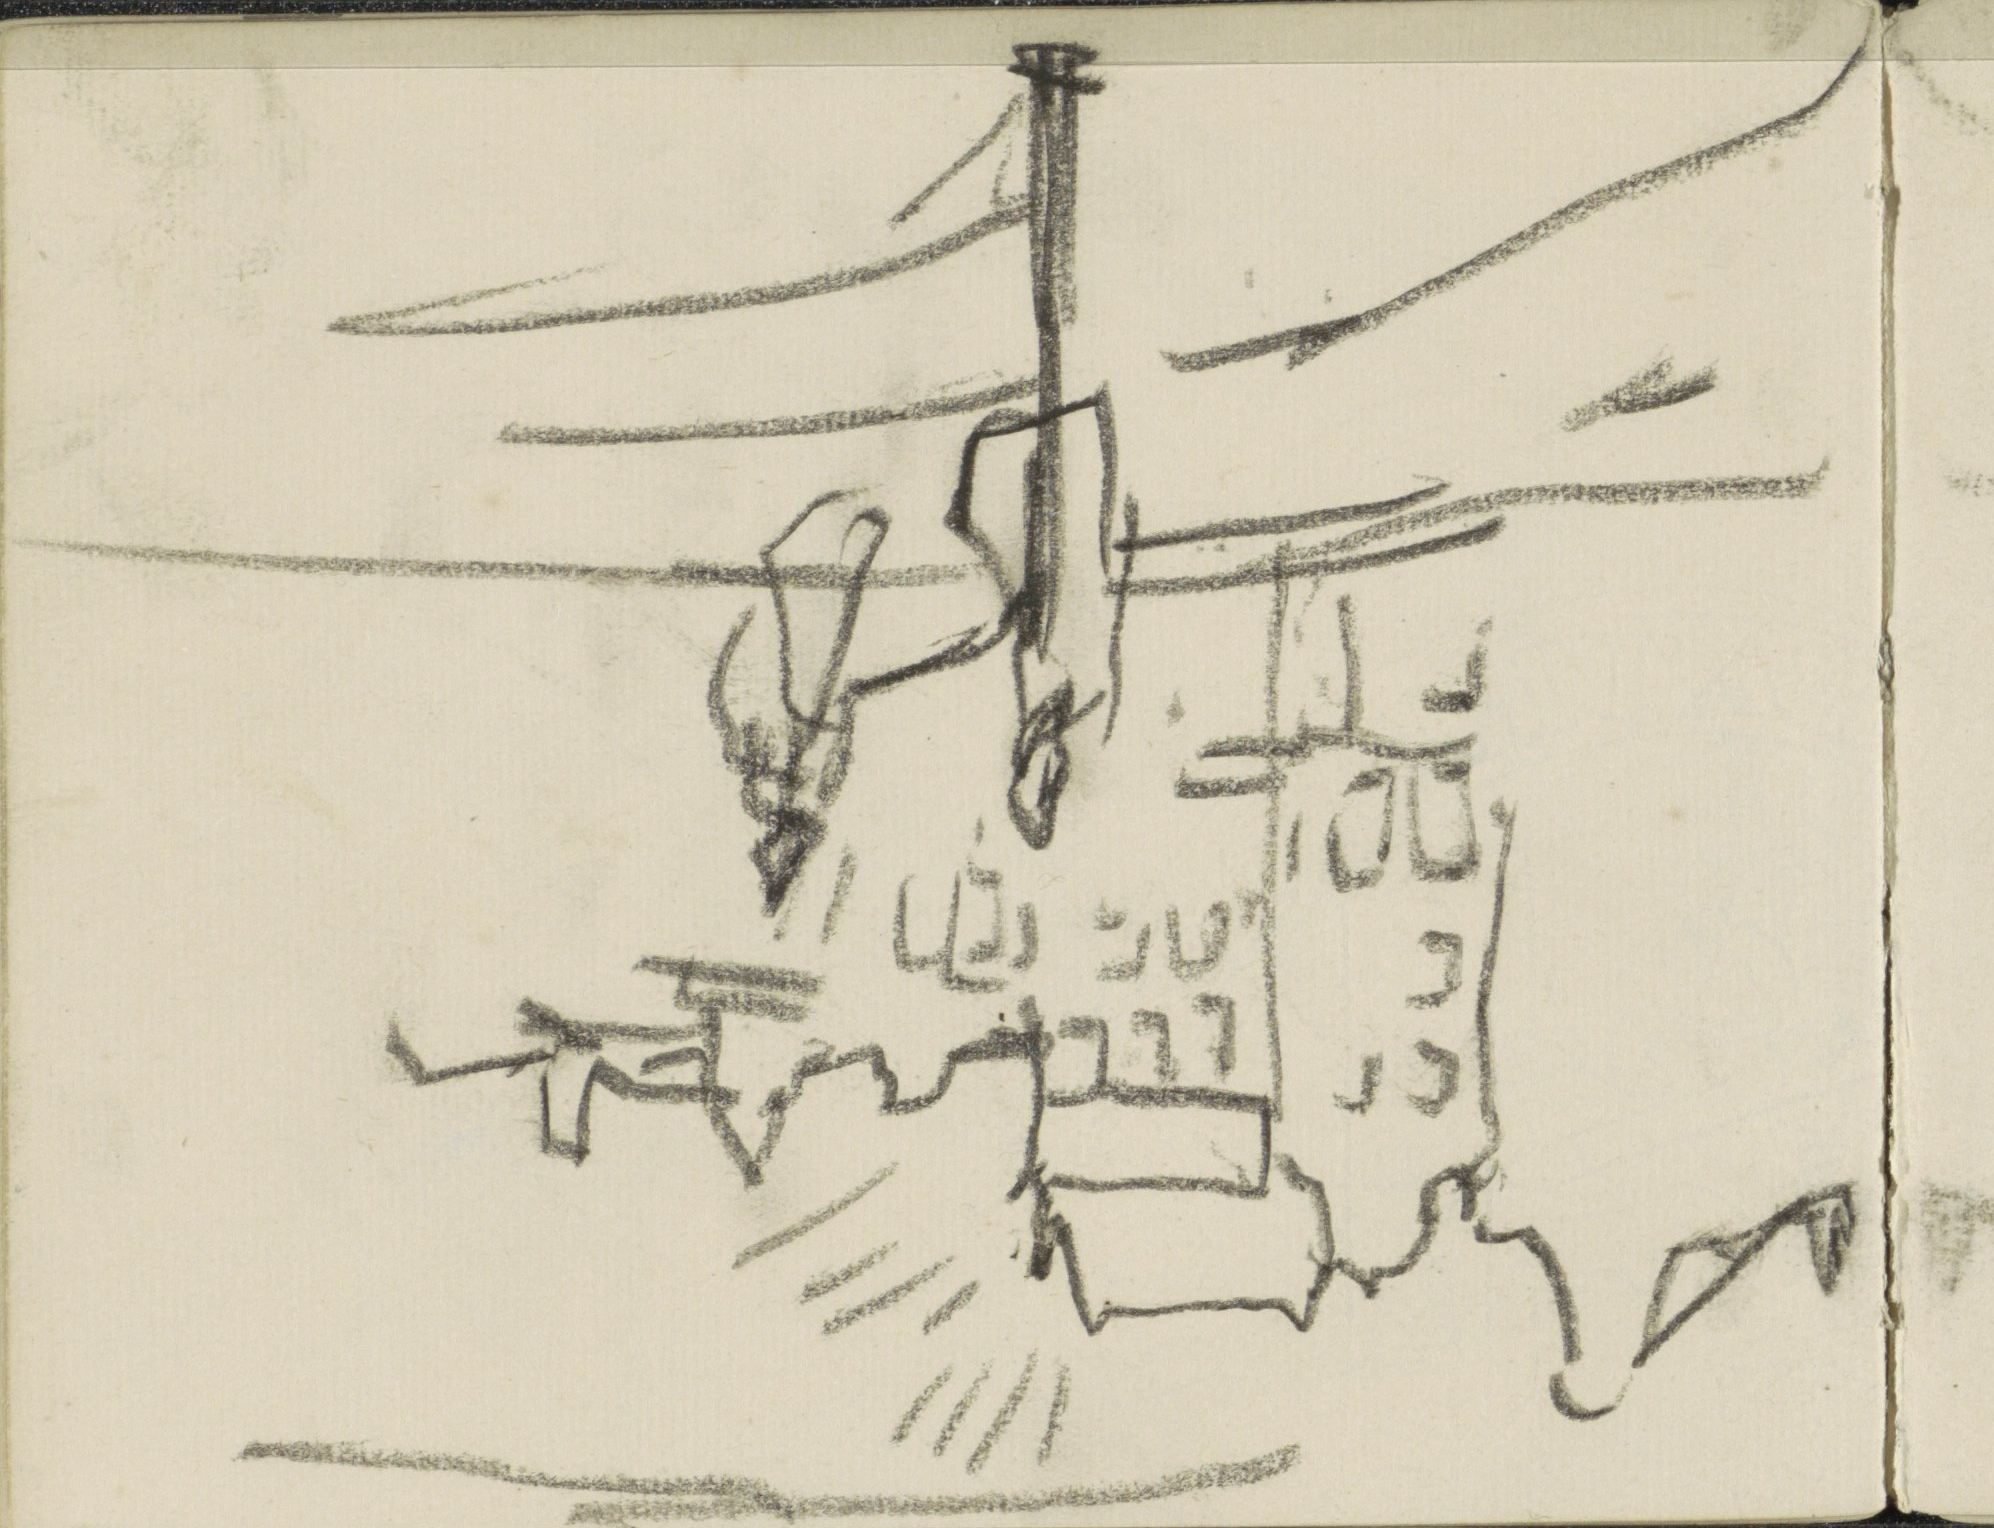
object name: sketchbook leaf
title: Figuren op een brug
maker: george hendrik breitner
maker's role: draughtsman, painter, print maker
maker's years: 1857-1923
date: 1886-1903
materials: chalk, paper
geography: amsterdam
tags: urban housing, bridge in city across river, canal, etc. (+ city(-scape) with figures, staffage), amsterdam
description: Op de achtergrond gebouwen. Pagina 45 uit een schetsboek met 32 bladen.